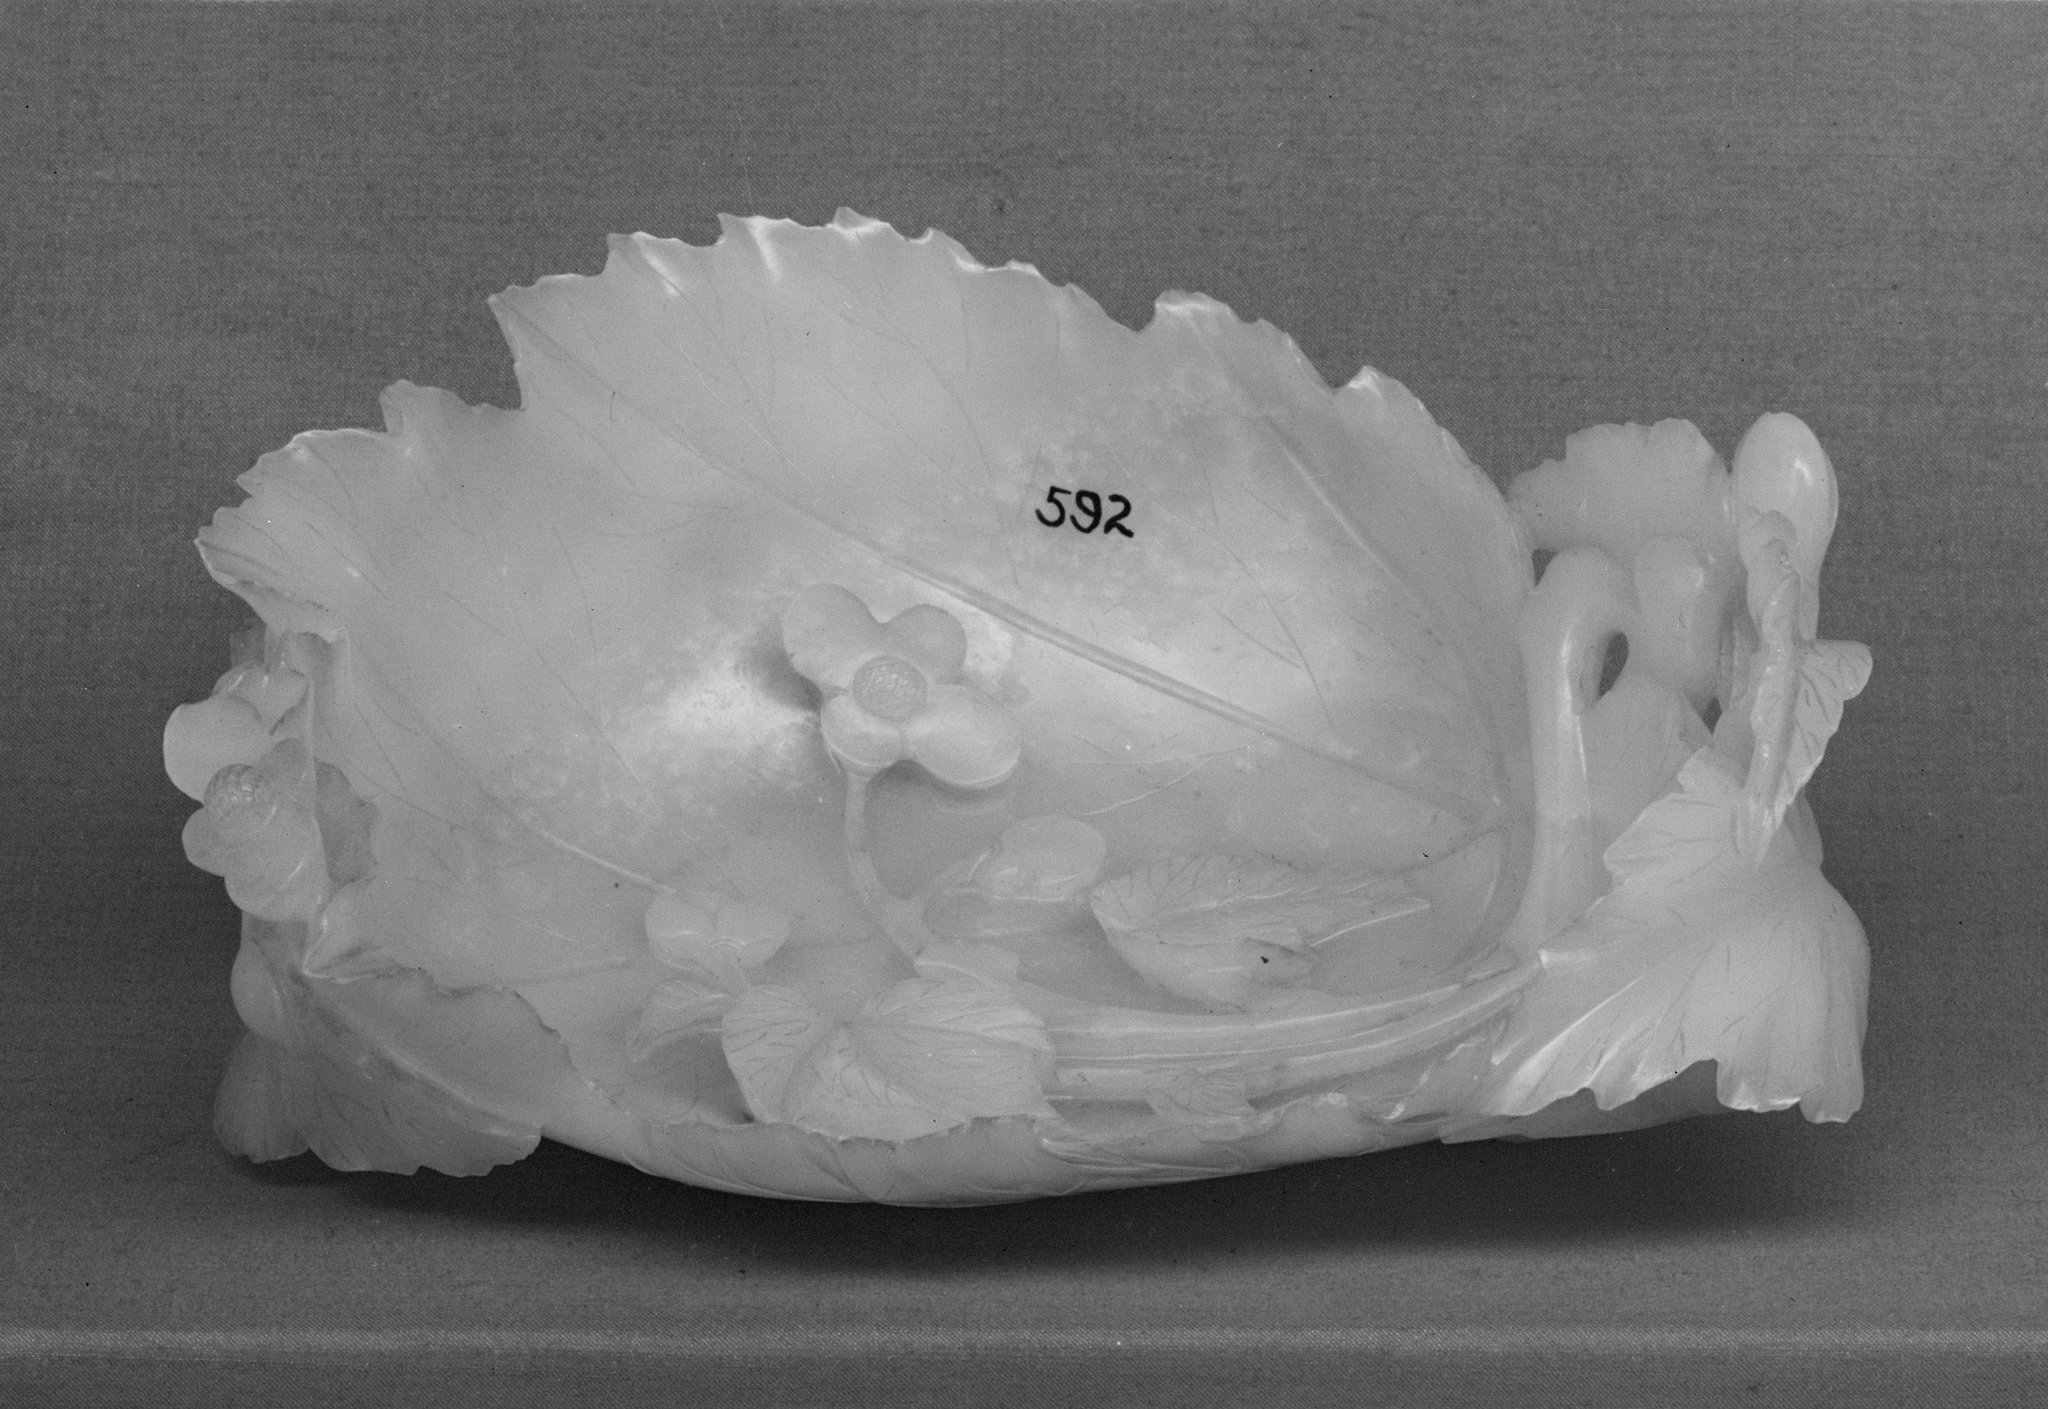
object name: artist's dish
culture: chinese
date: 1736-1795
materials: jade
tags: flowers,leaves